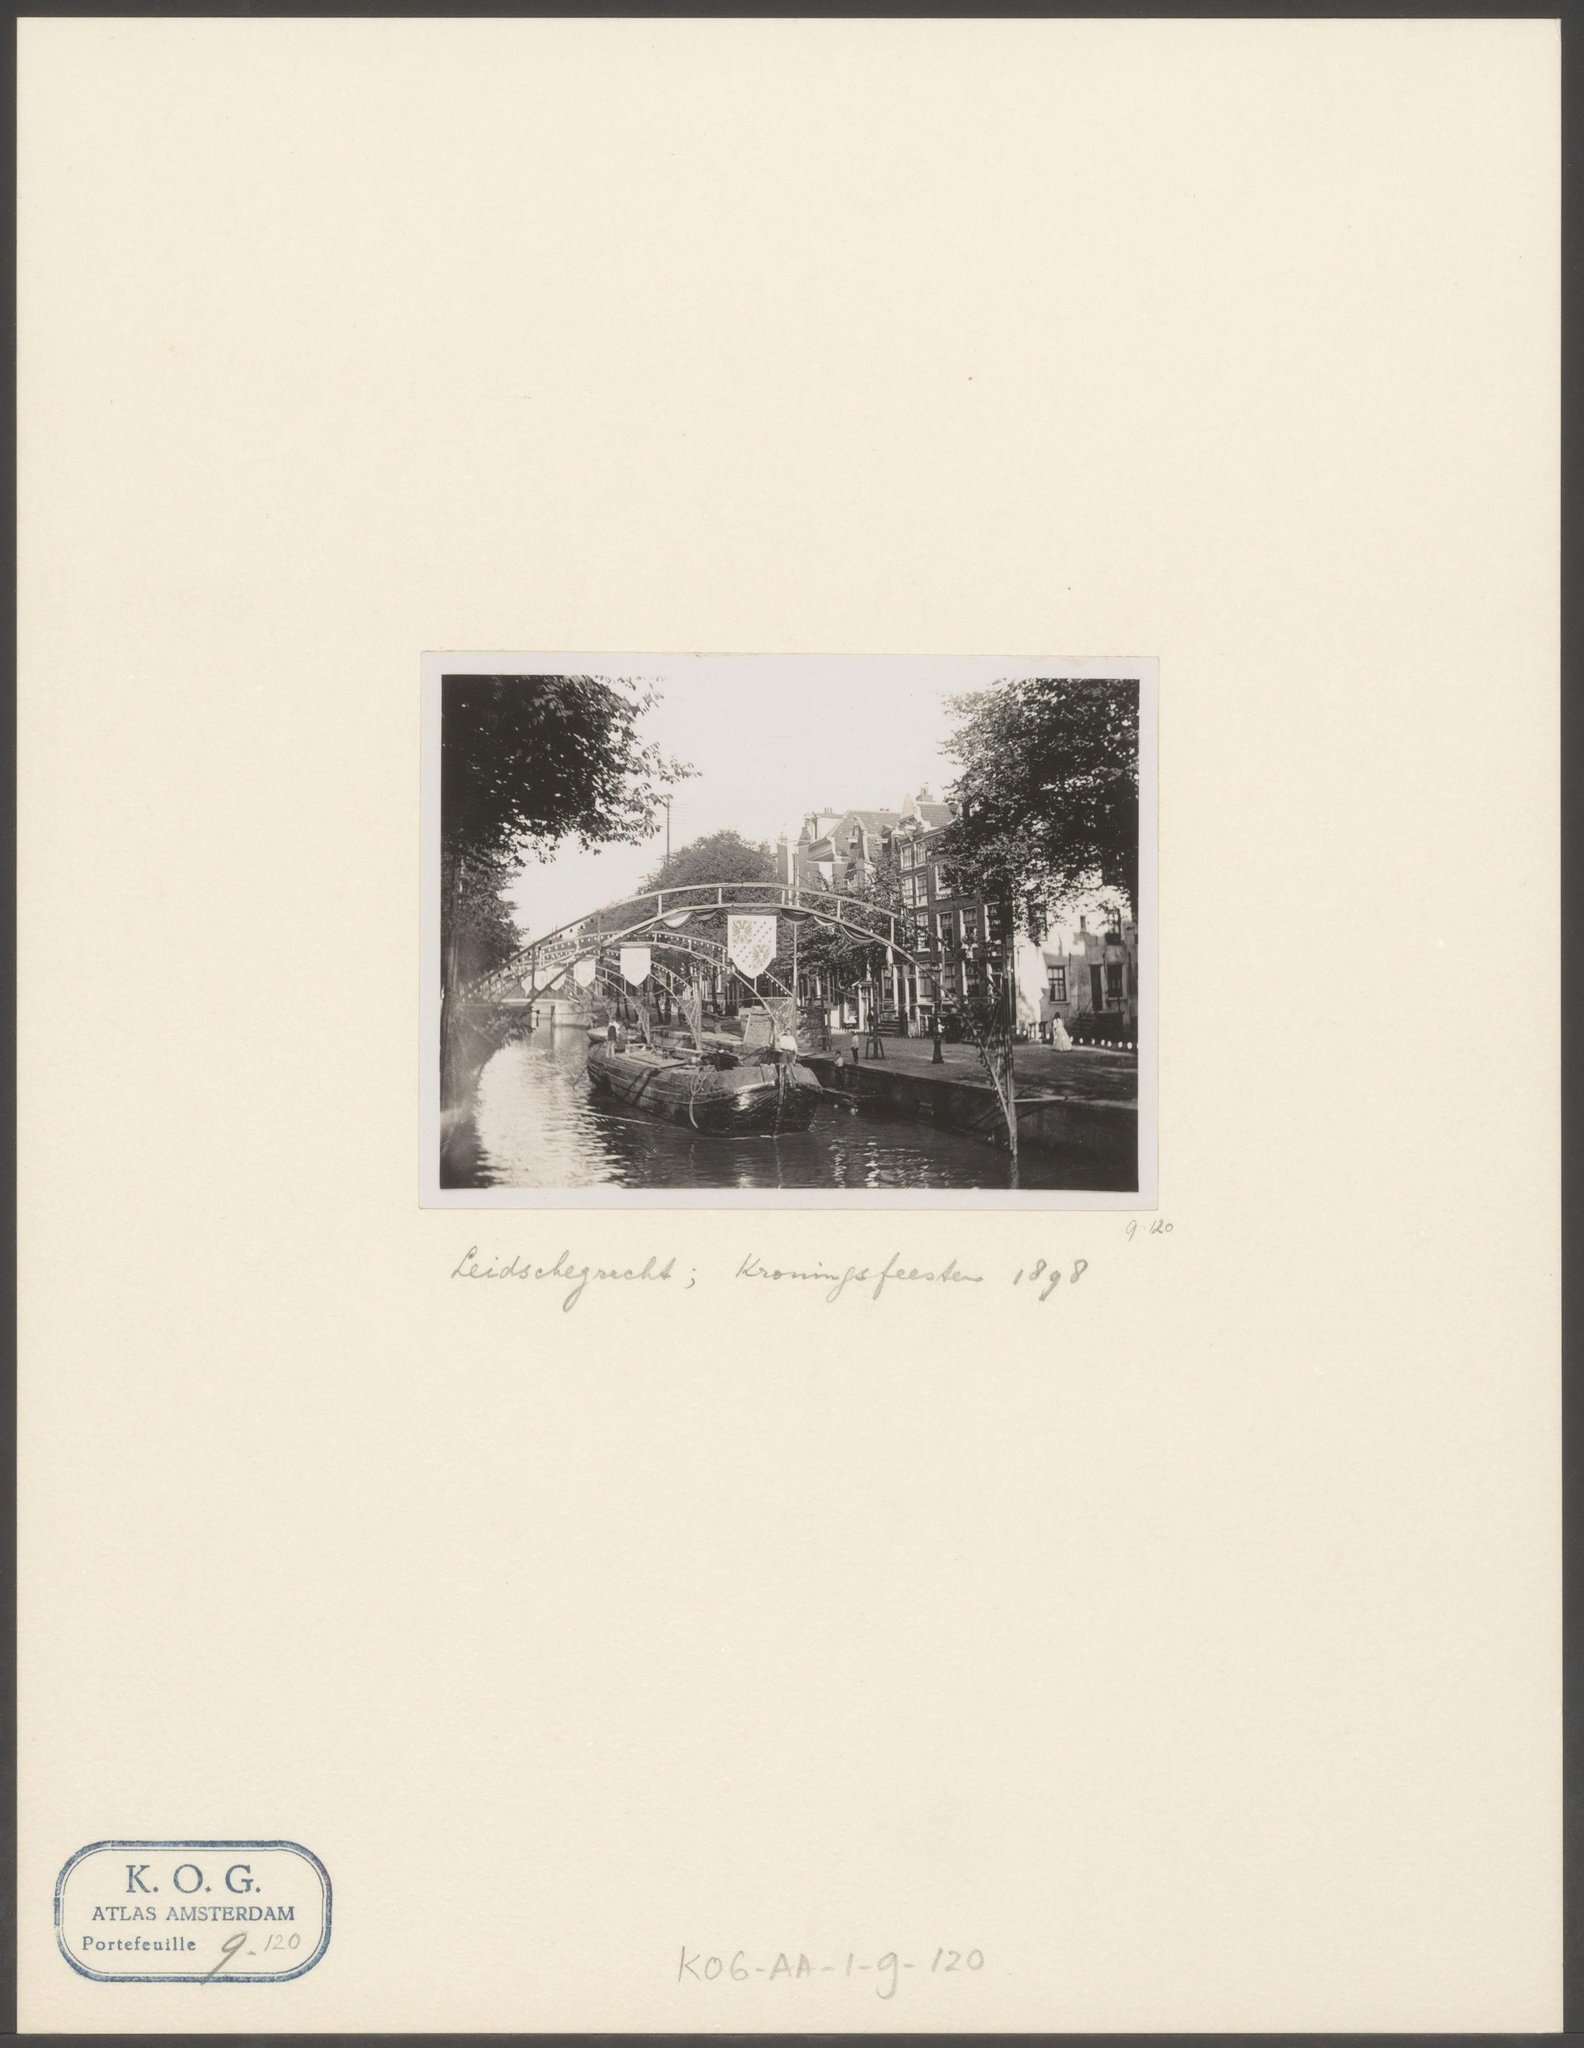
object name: photograph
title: Gezicht op de Leidsegracht tijdens de Kroningsfeesten van 1898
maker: Anonymous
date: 1898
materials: paper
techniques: gelatin silver print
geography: amsterdam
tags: city-view in general; 'veduta', public festivities at other royal events, not meant or mentioned above - aa - festivities on the water, canal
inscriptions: collector's mark: ‘9.120’ Lugt 1641b, inscription: ‘Leidschegracht; Kroningsfeesten 1898’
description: Onderwerpsrubriek binnen de Atlas Amsterdam: 2e Laurierdwarsstraat (Vuile Weespad), Leidschegracht, Leidschekade, Leidscheplein, Leidschestraat, v. Lennepkade, Lijnbaansgracht, Lauriergracht, Leliedwarsstraat, Leliegracht, Lindengracht, Lombardsteeg, Looiersgracht, Looiersstraat (Nieuwe), Leidekkerssteeg.